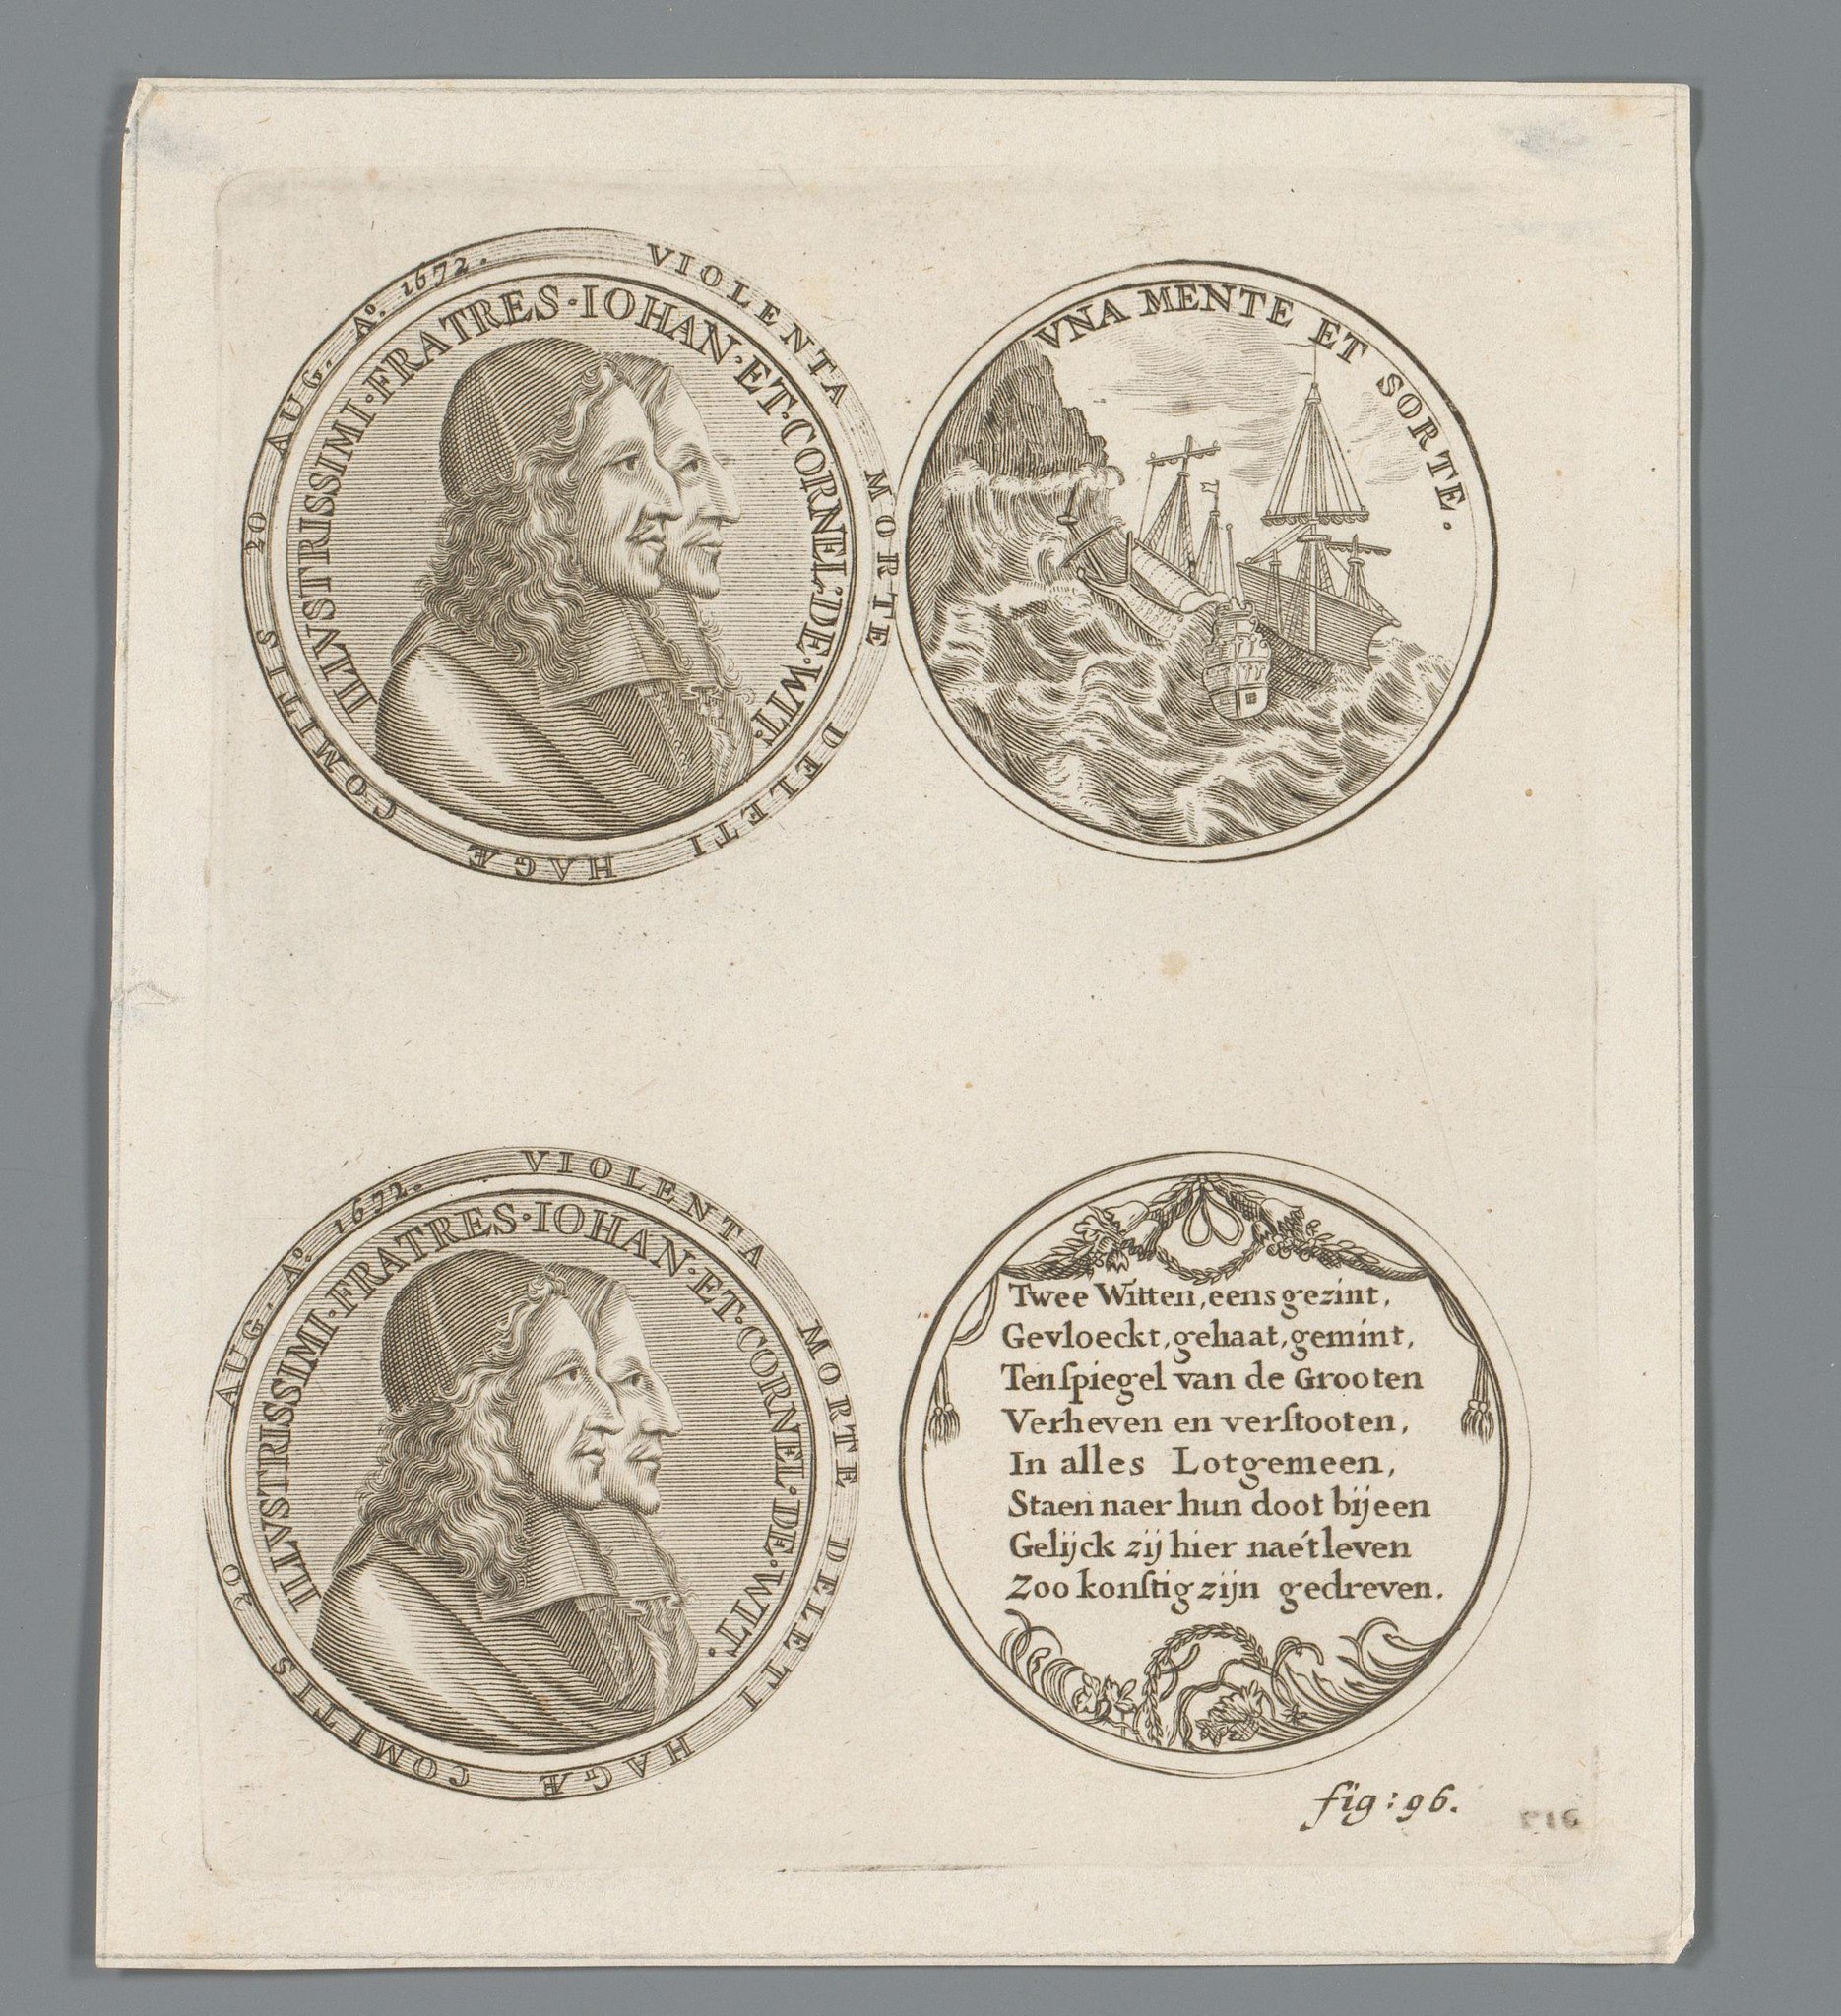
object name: book illustration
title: Voor- en achterzijden van twee penningen met daarop de portretten van Johan en Cornelis de Witt, een zeegevecht en een gedicht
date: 1690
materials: paper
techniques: etching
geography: amsterdam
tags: cornelis de witt, the hague, politician, johan de witt, battle (+ naval force), historical persons, politician, e.g. party leader, coin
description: Prent uit: Bizot, Pierre. Medalische historie der republyk van Holland. Amsterdam: Pieter Mortier, 1690, dl. 1.